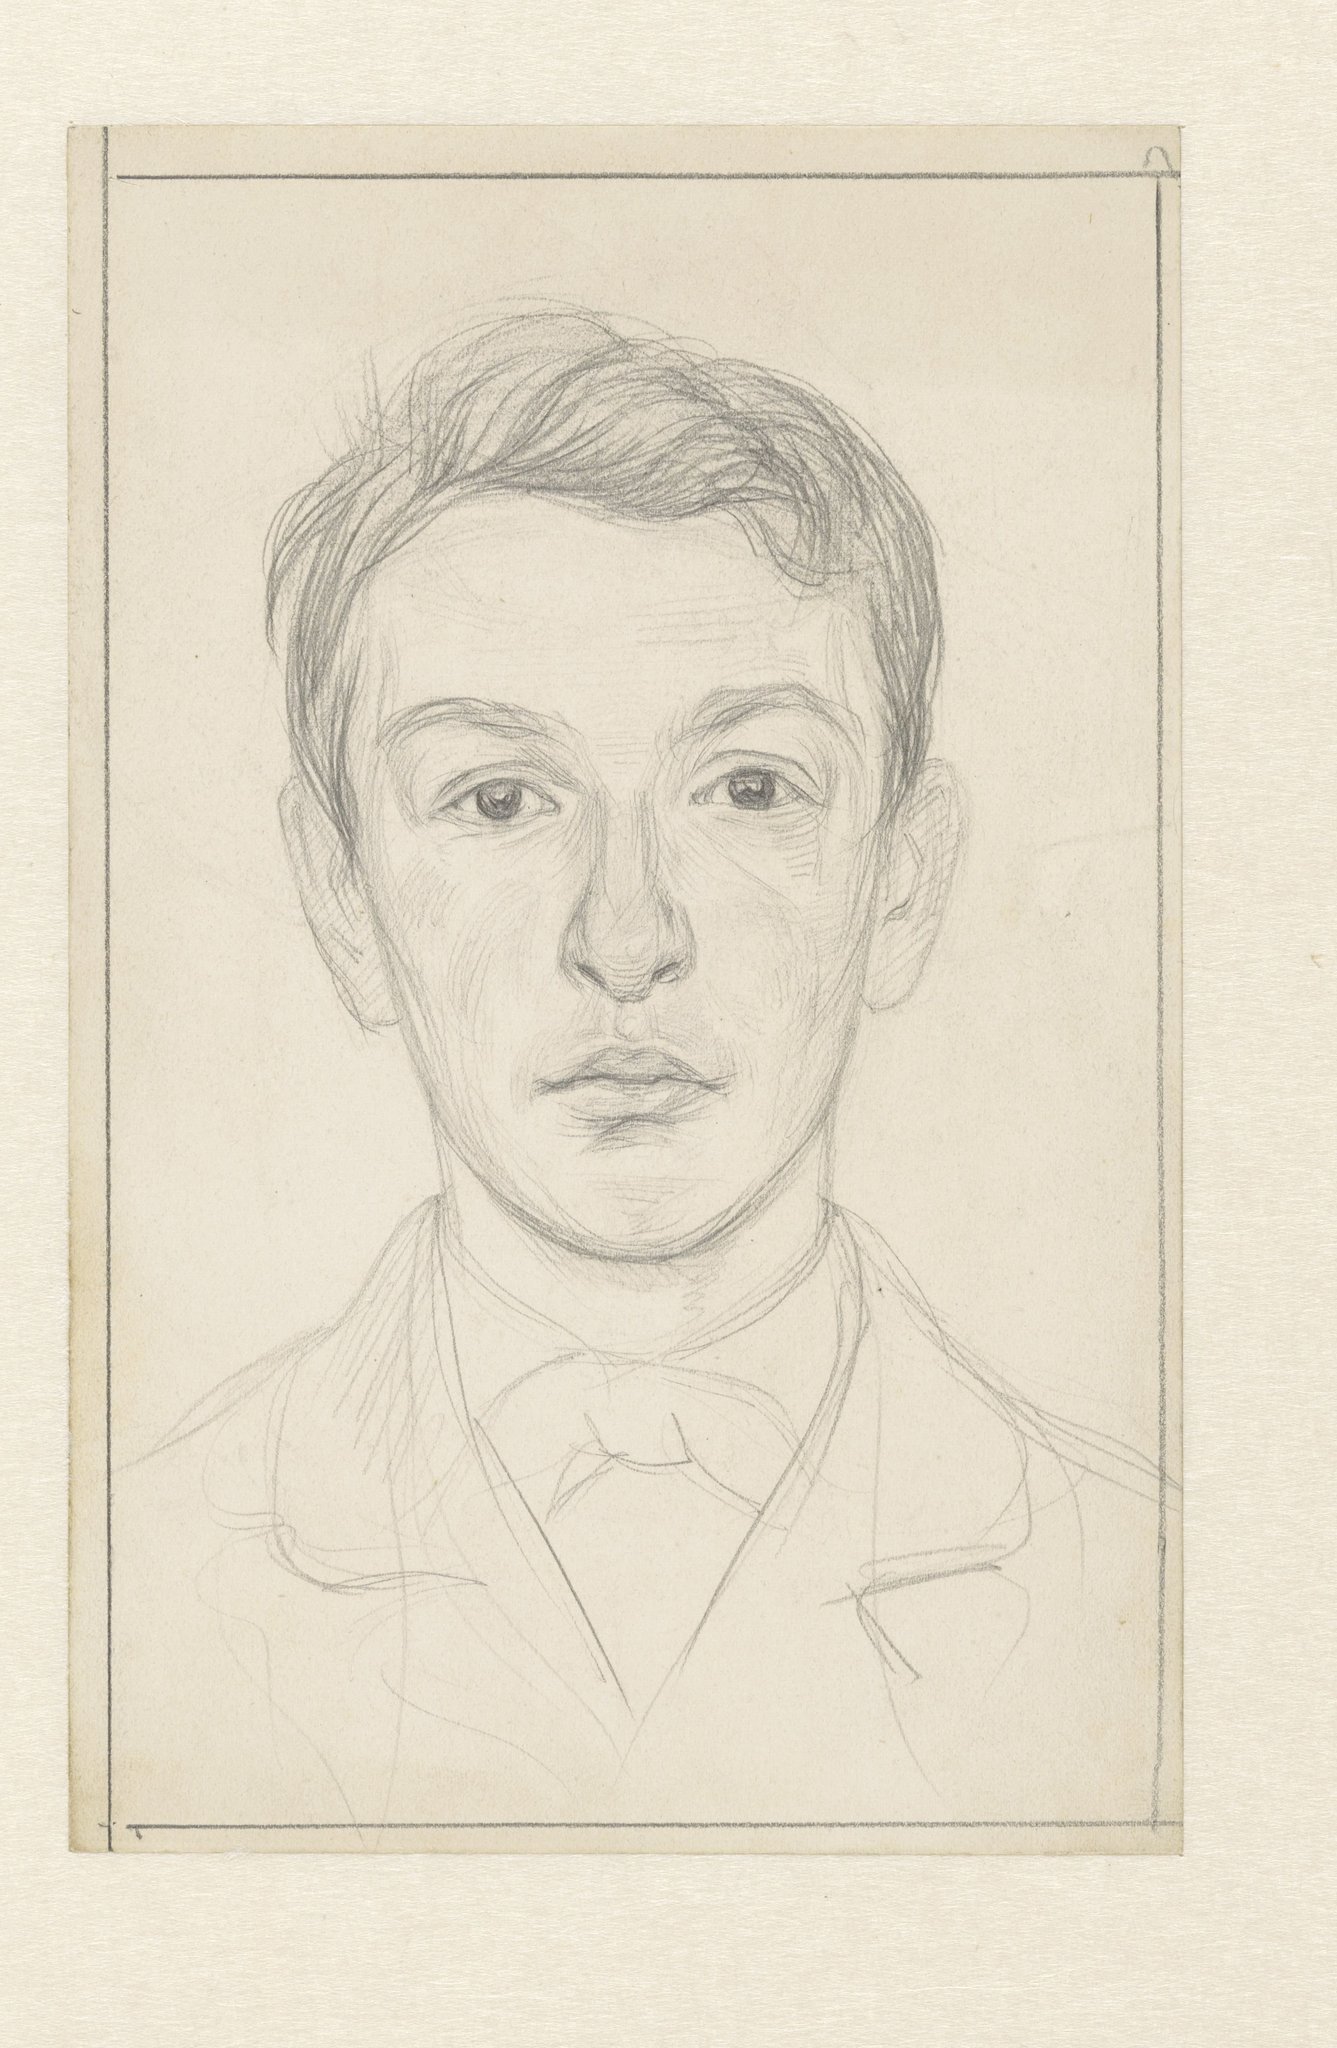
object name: drawing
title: Portret van een jongen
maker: jan veth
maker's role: designer, draughtsman, painter, print maker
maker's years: 1864-1925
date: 1874-1925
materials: paper, pencil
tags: anonymous historical person portrayed alone